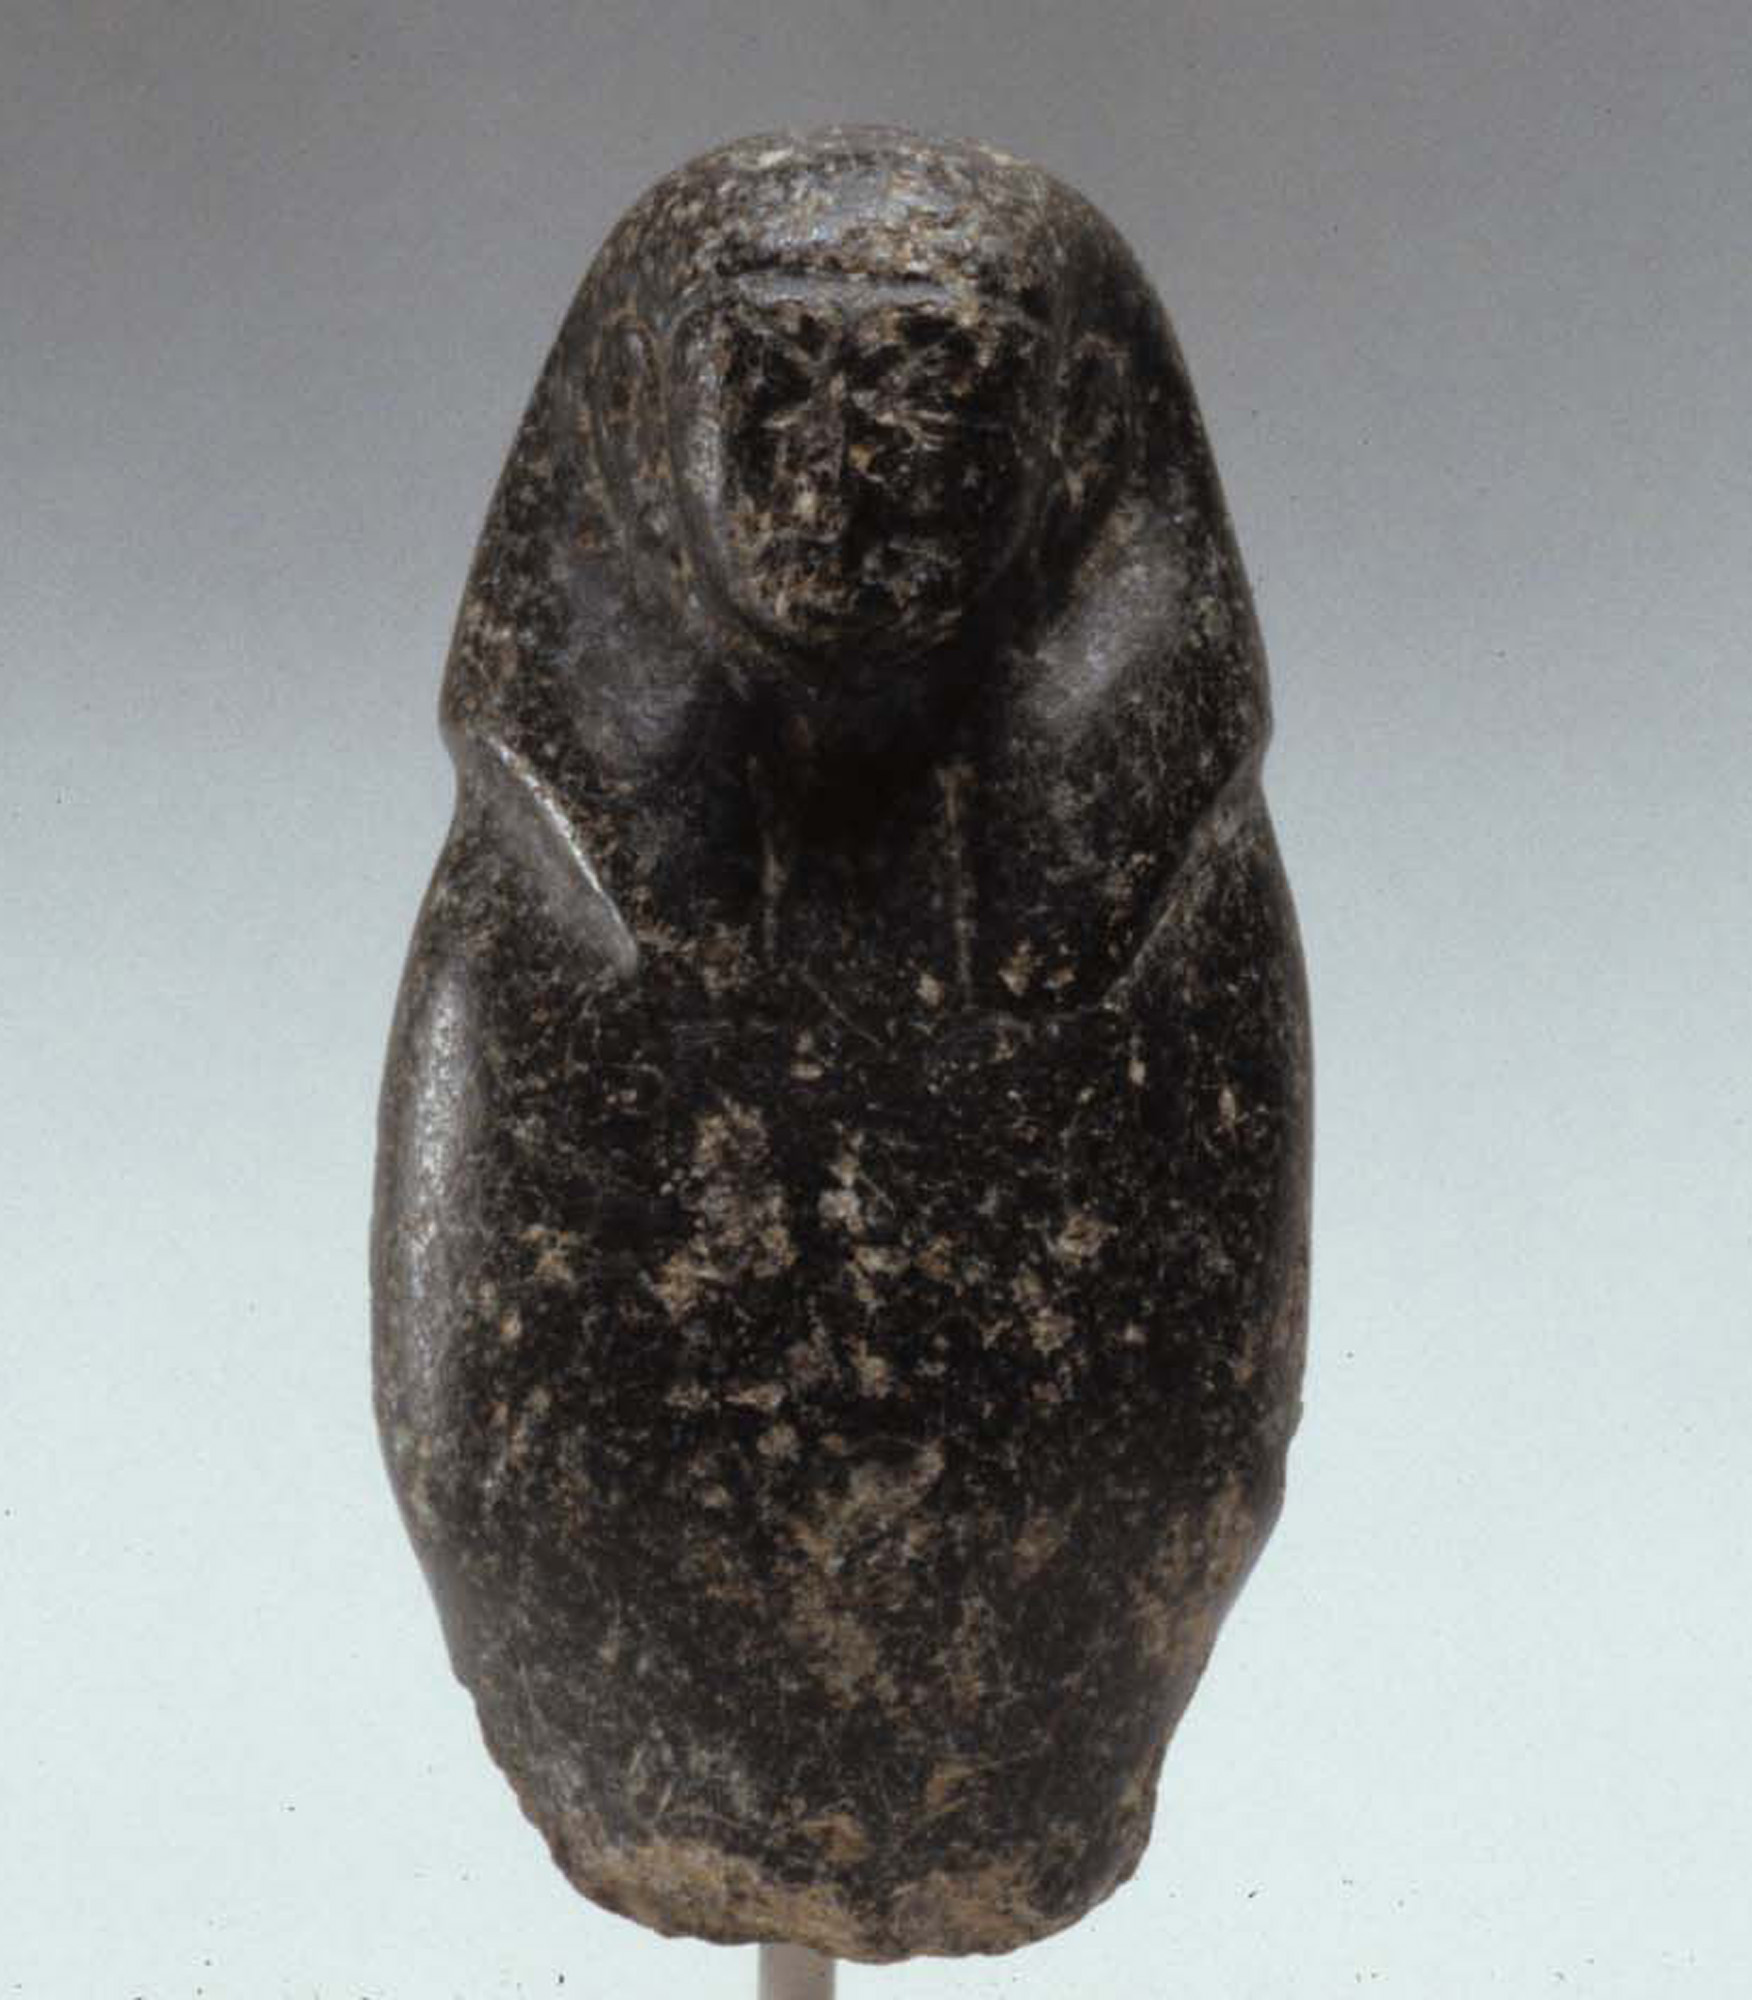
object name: shabti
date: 1850-1640 BCE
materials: stone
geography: egypt